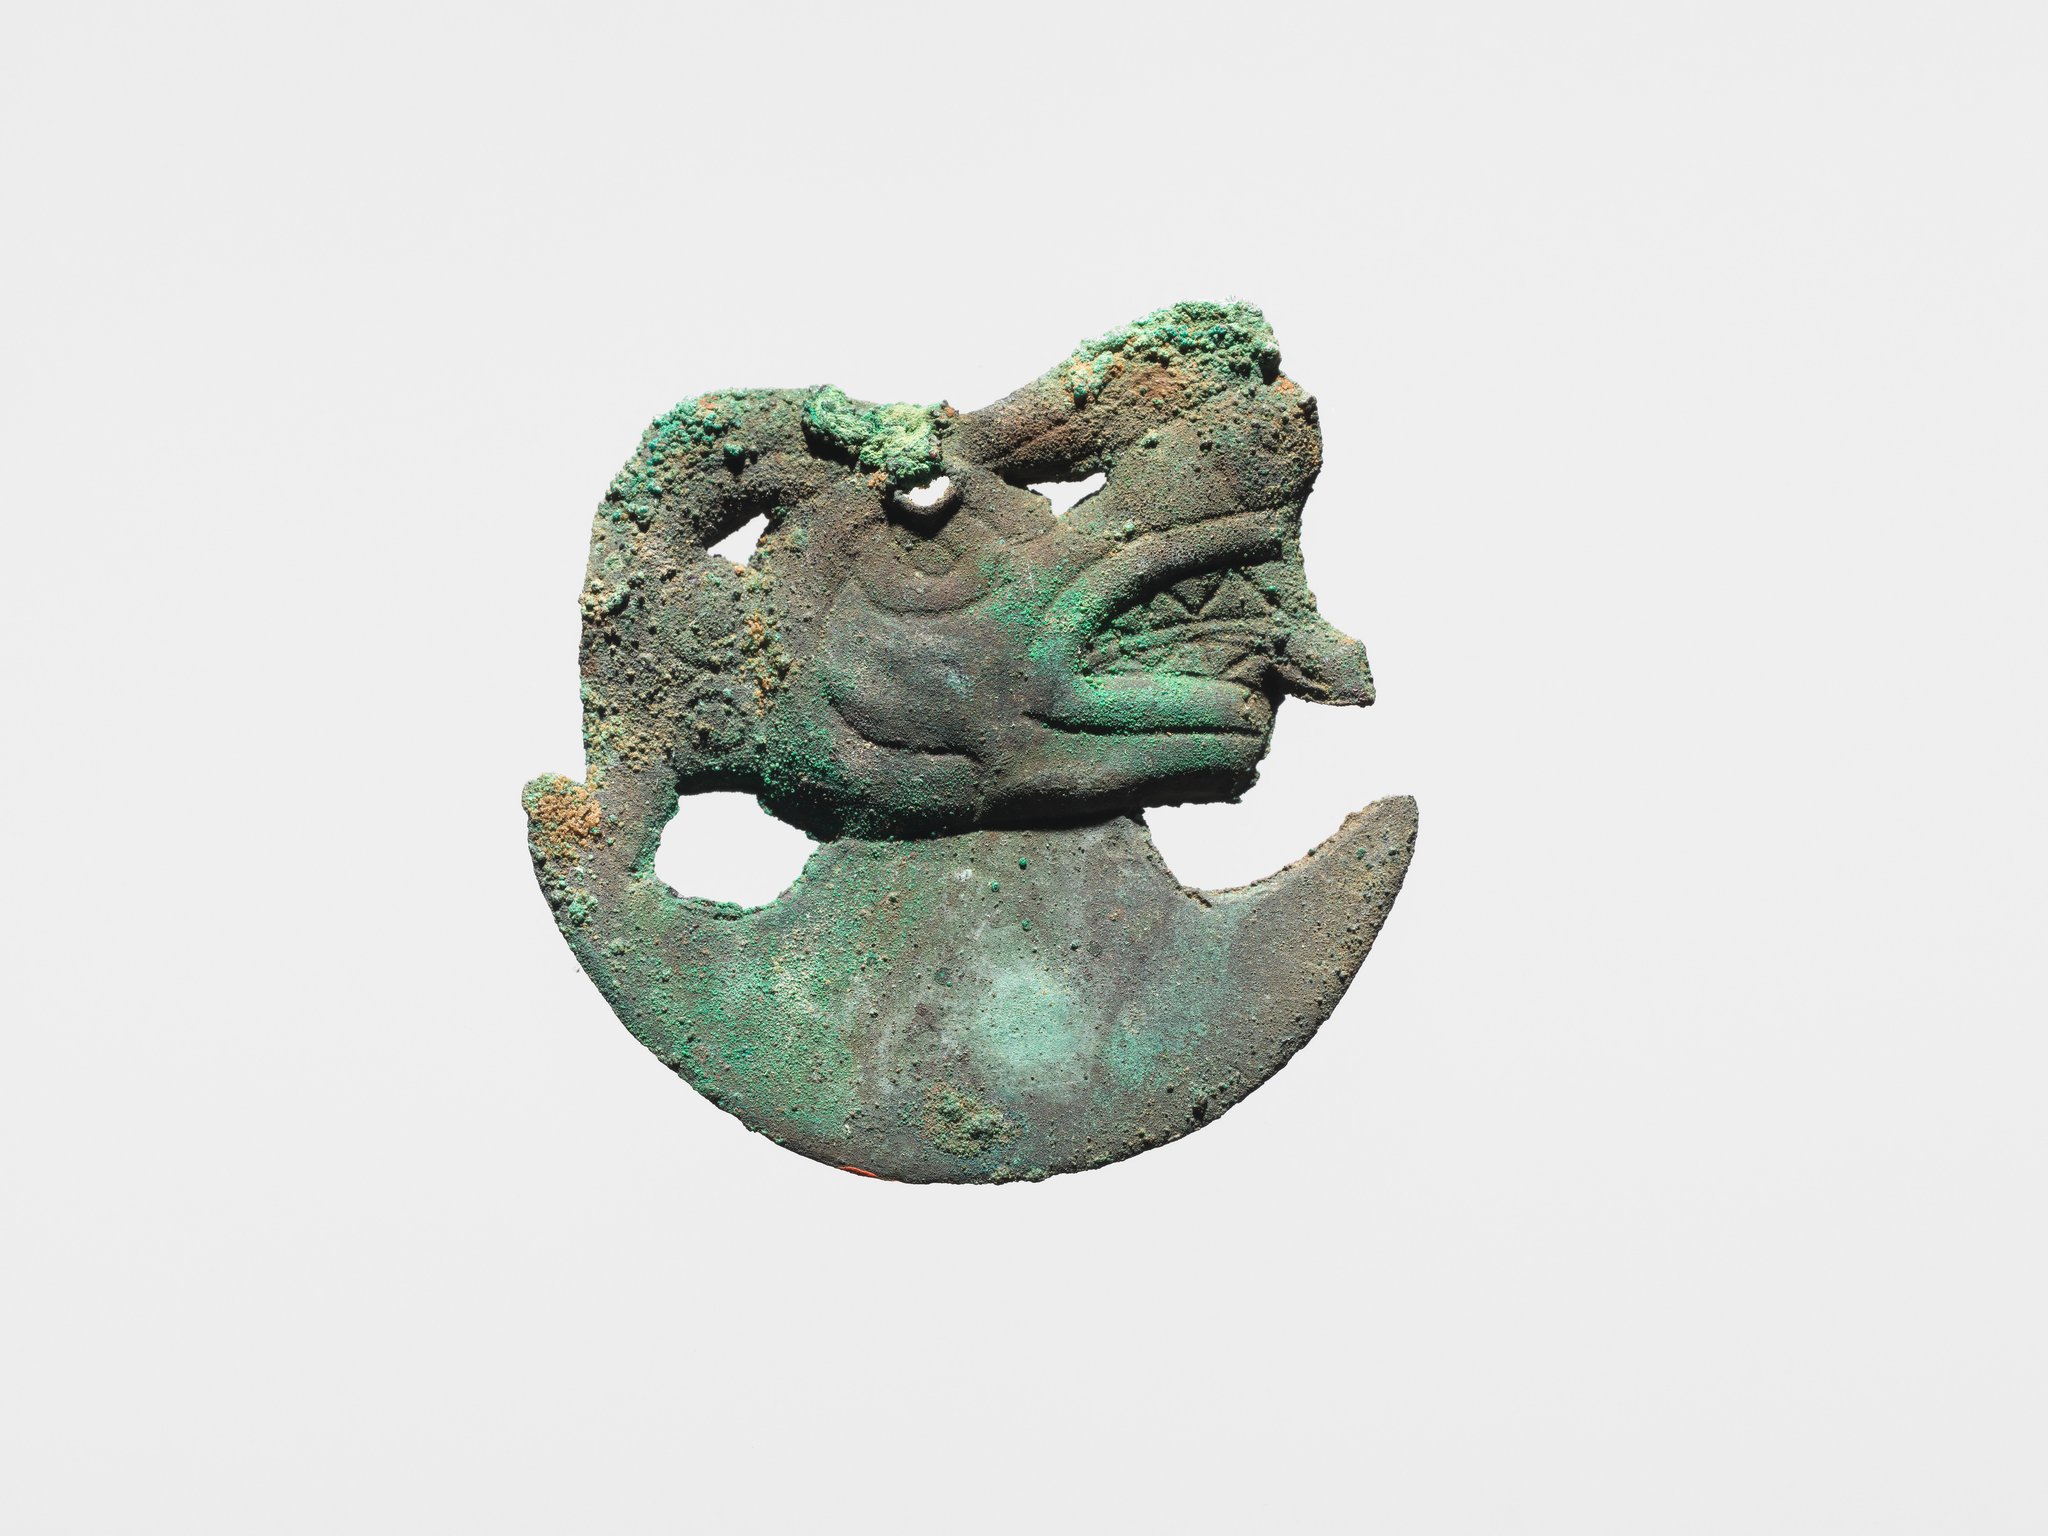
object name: ornament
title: Crescent Ornaments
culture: moche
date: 501-700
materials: copper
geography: peru